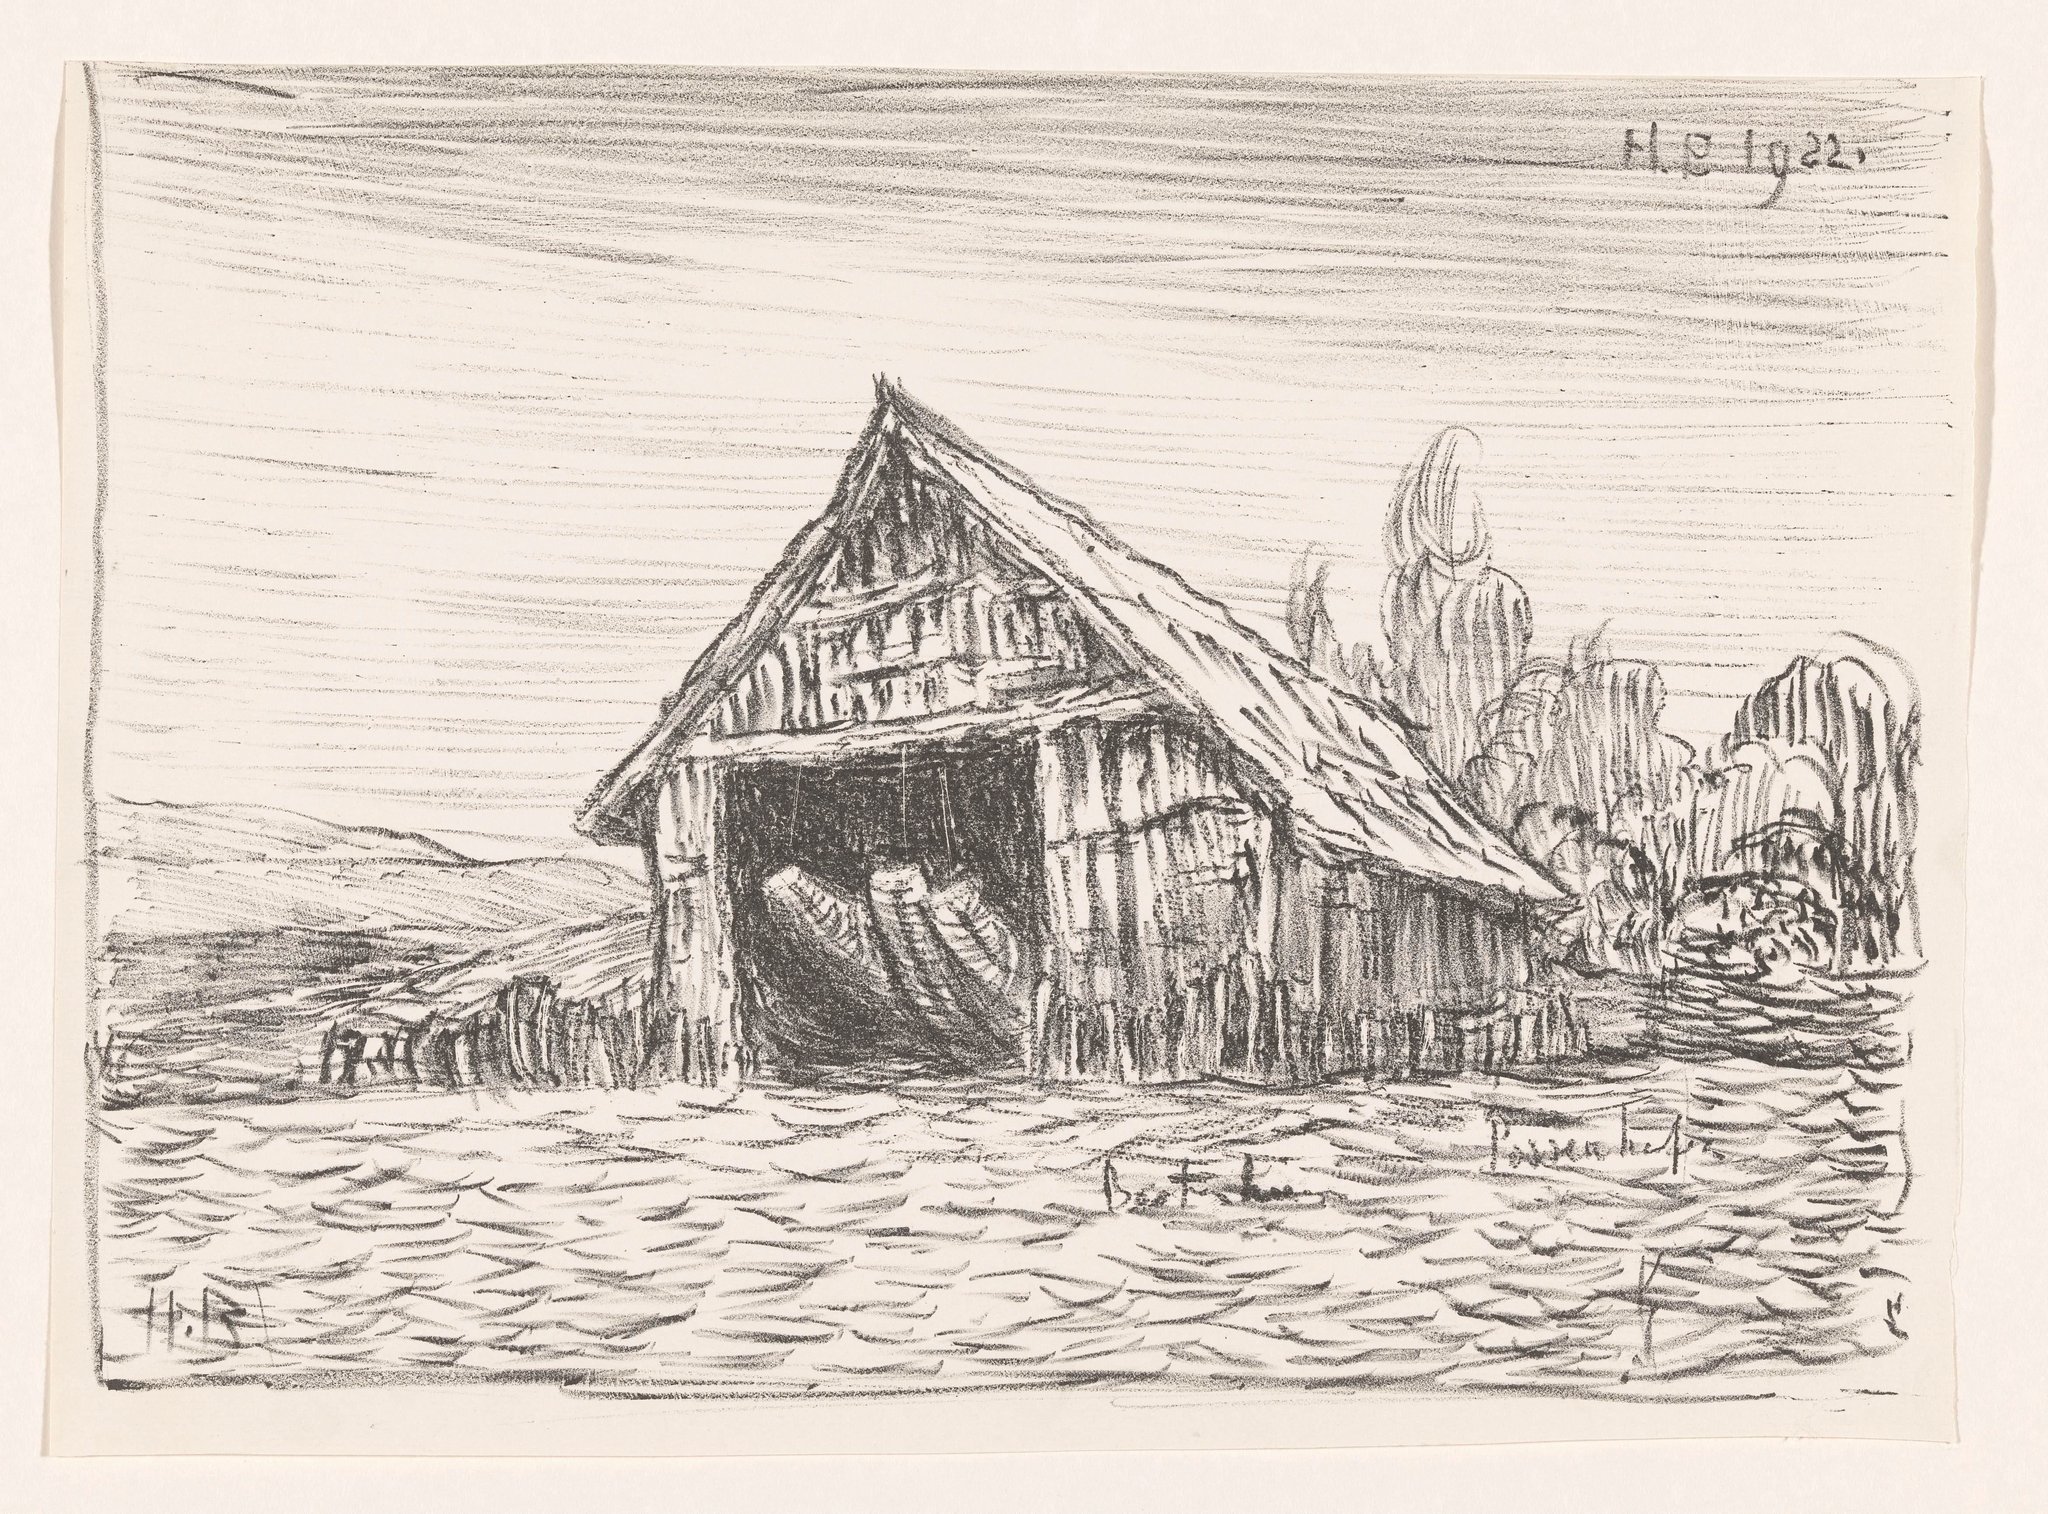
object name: print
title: Boothuis in Possenhofen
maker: henri braakensiek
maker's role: print maker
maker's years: 1891-1941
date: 1922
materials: paper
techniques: lithograph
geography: munich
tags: lake, boat-house, shed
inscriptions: collector's mark: Lugt 2228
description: Een boothuis aan de Starnberger See in Beieren.